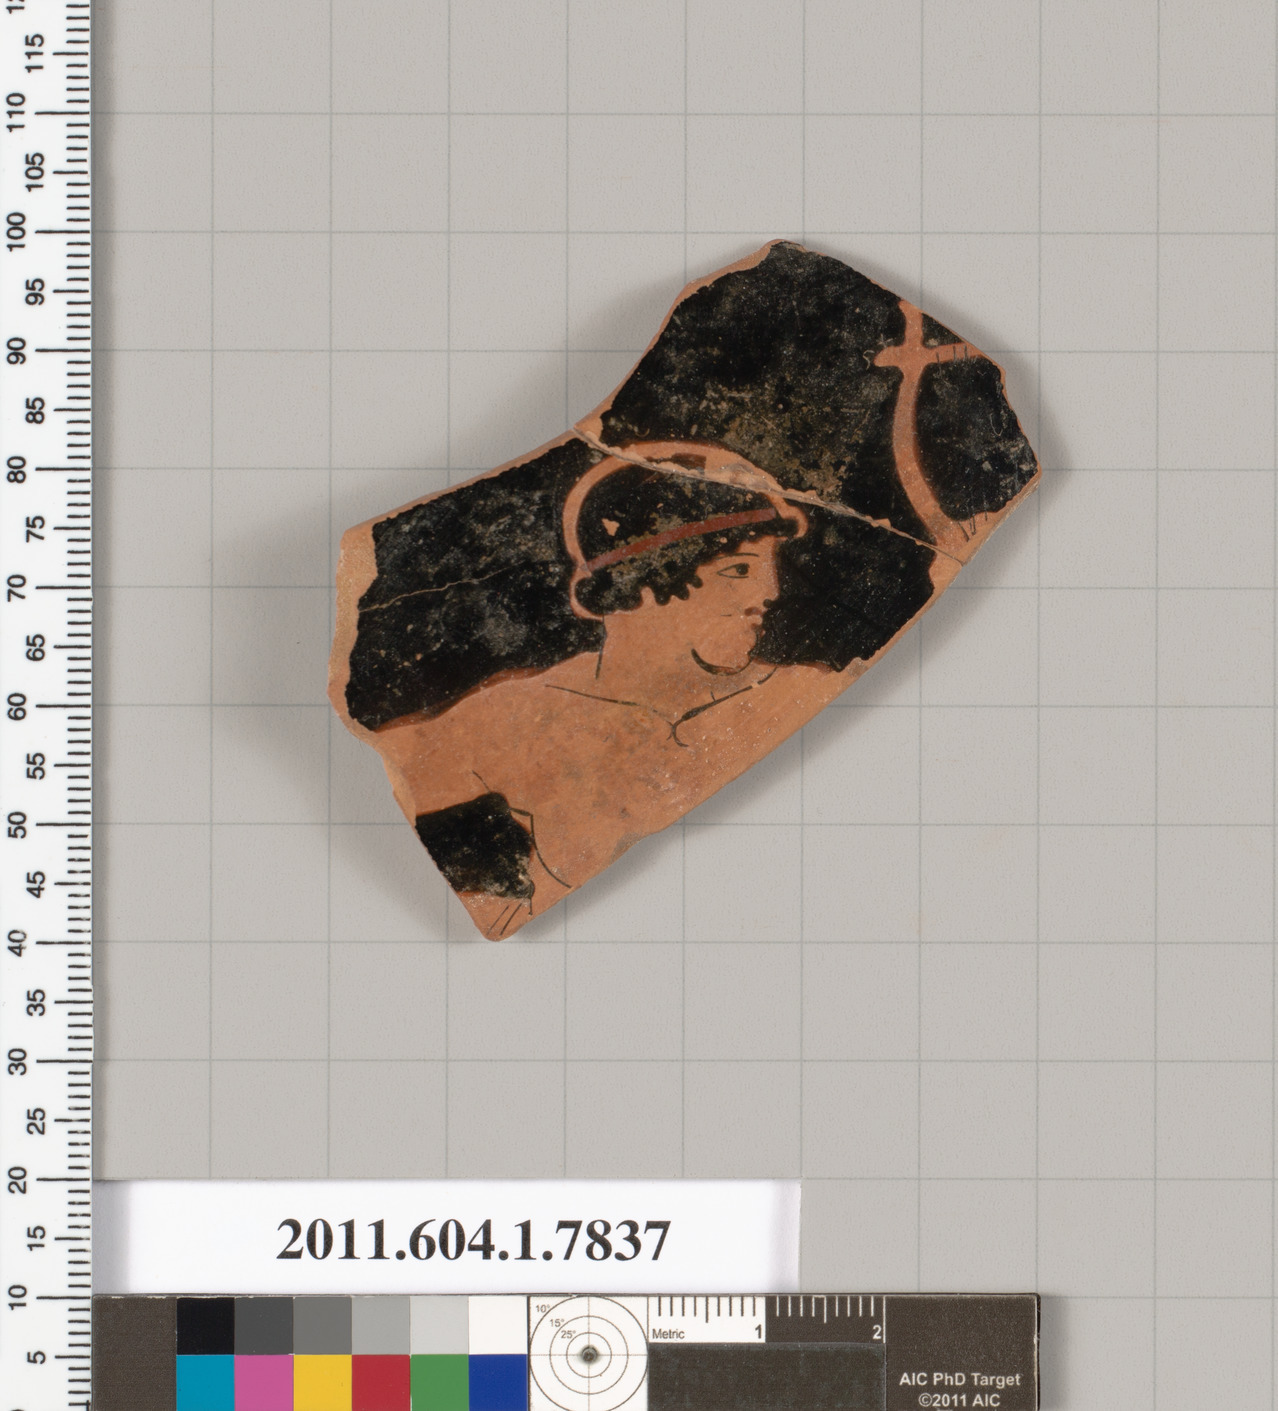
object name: kylix fragment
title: Terracotta fragment of a kylix (drinking cup)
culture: greek, attic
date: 460-450 BCE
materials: terracotta